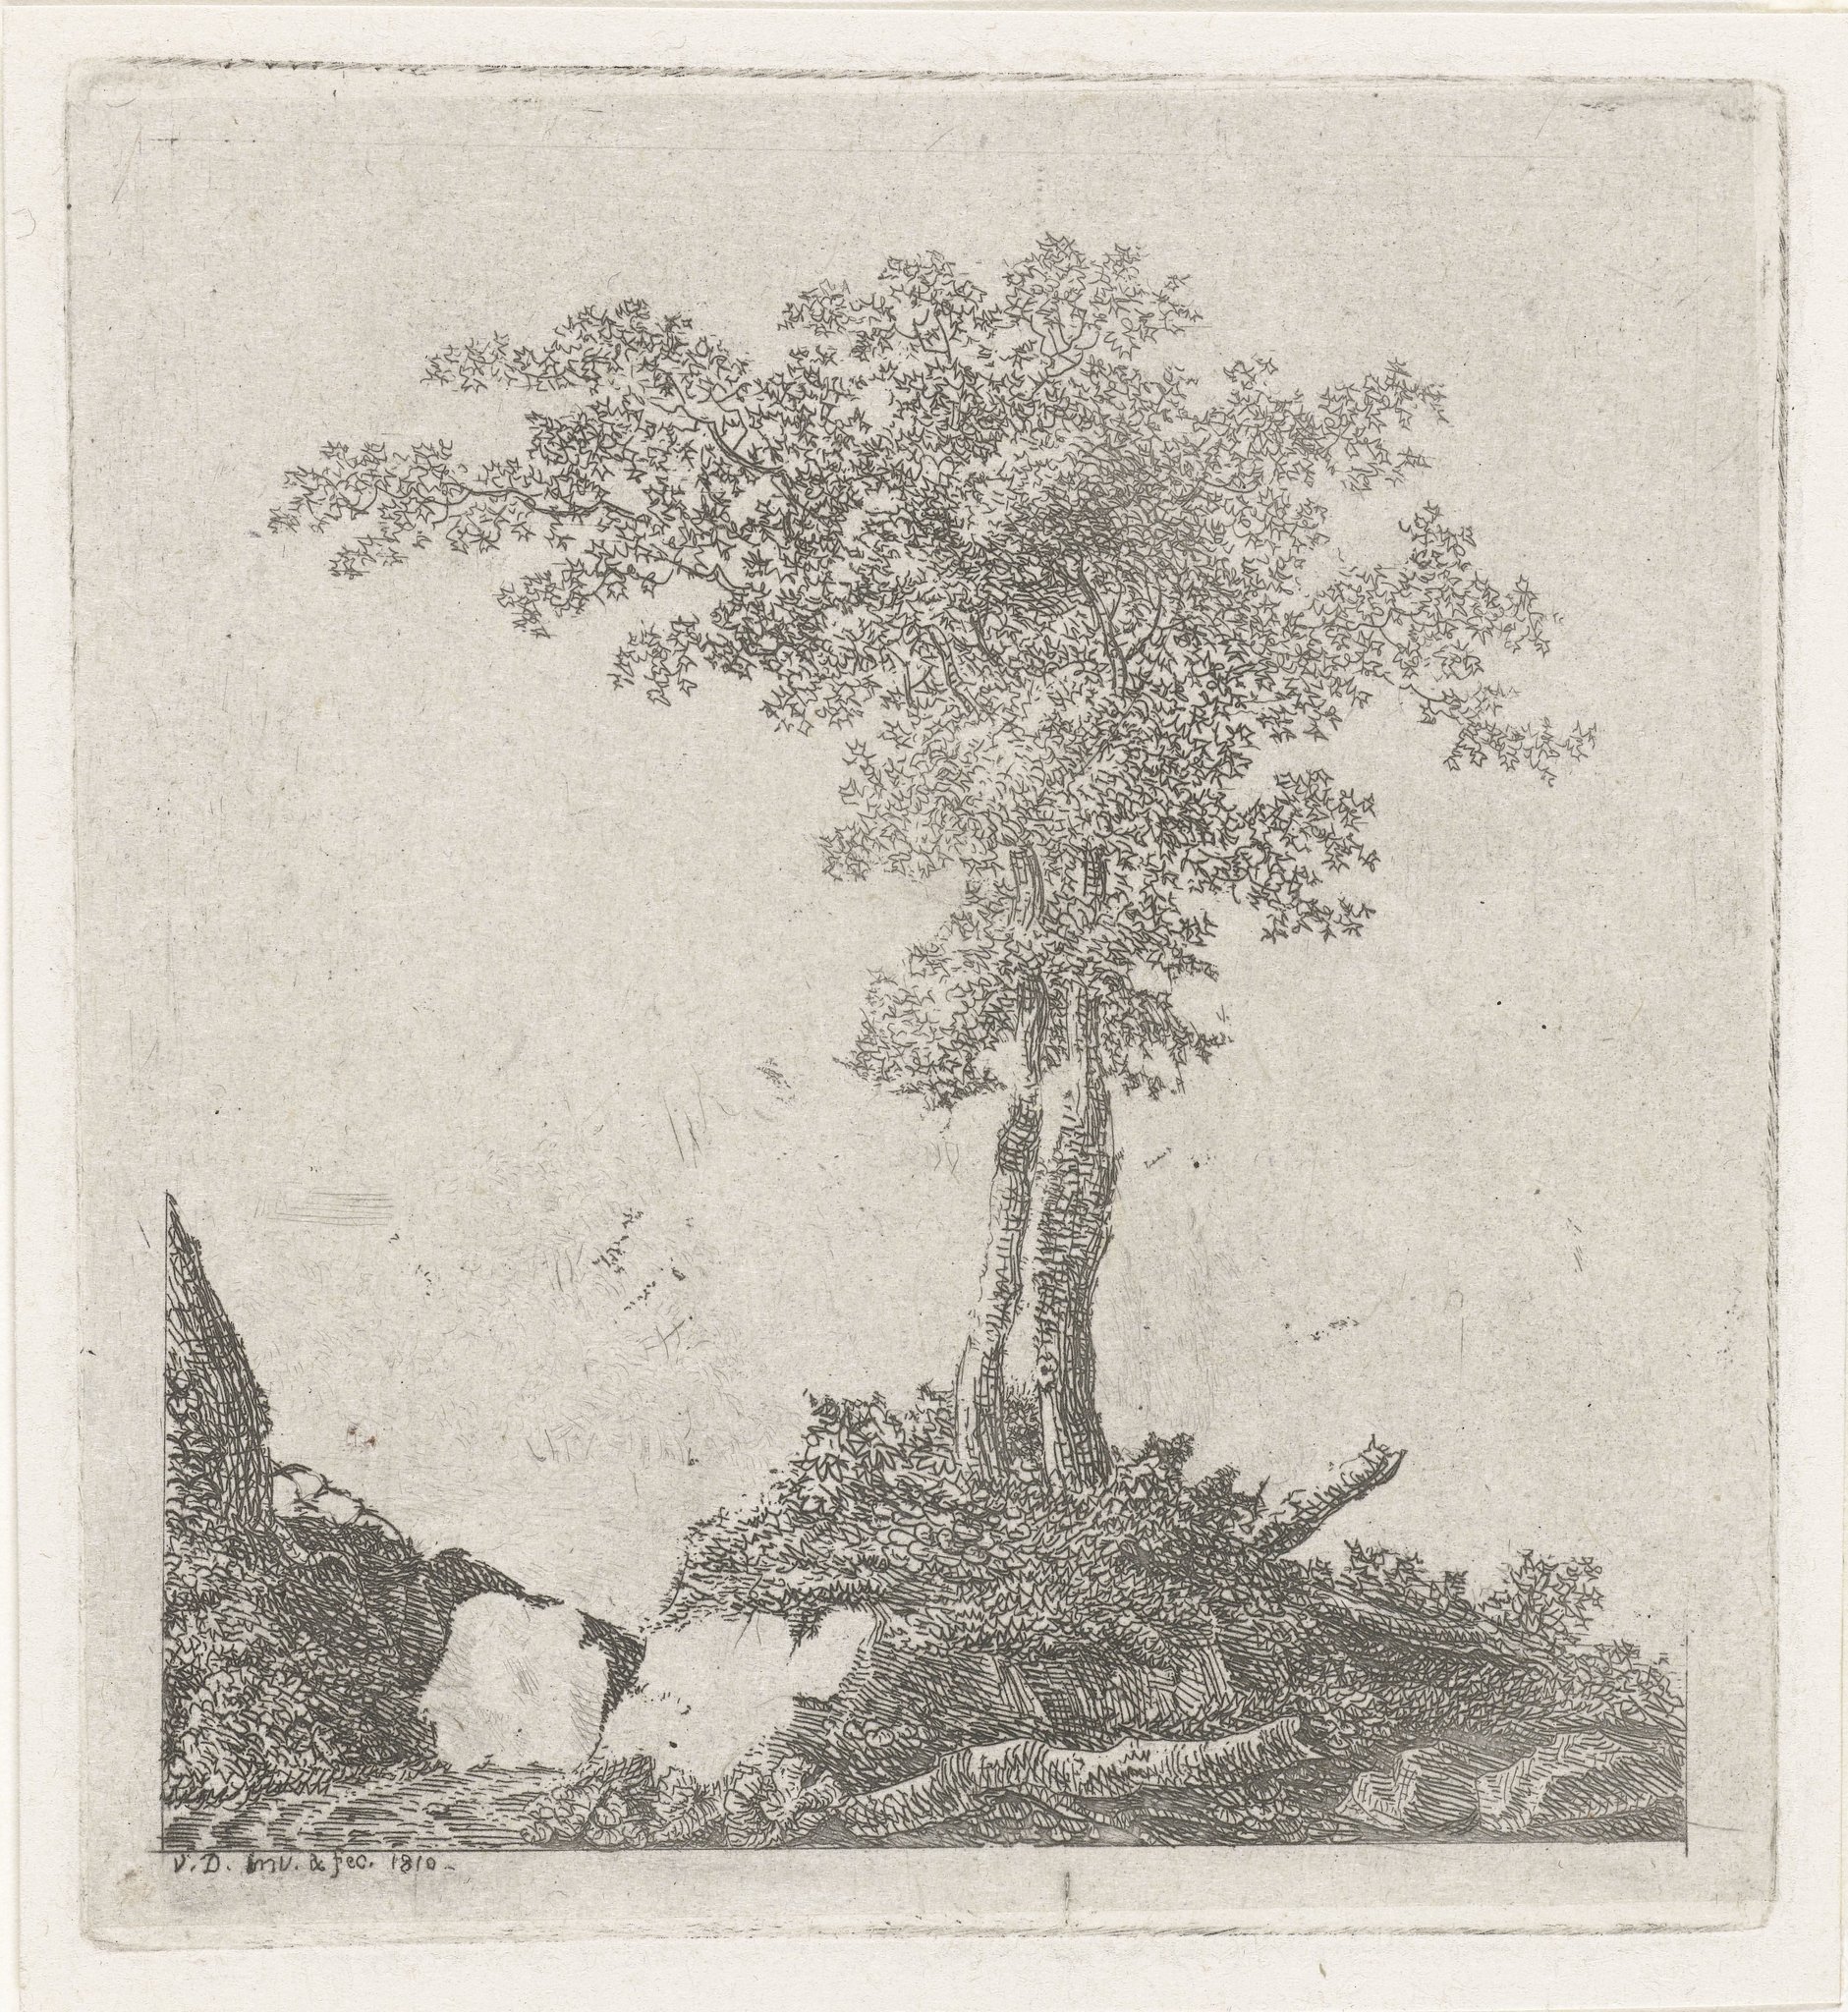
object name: print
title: Twee bomen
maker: adriaan jacob willem van dielen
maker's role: print maker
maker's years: 1772-1812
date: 1810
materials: paper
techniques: etching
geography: netherlands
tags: trees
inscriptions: collector's mark: Lugt 2228